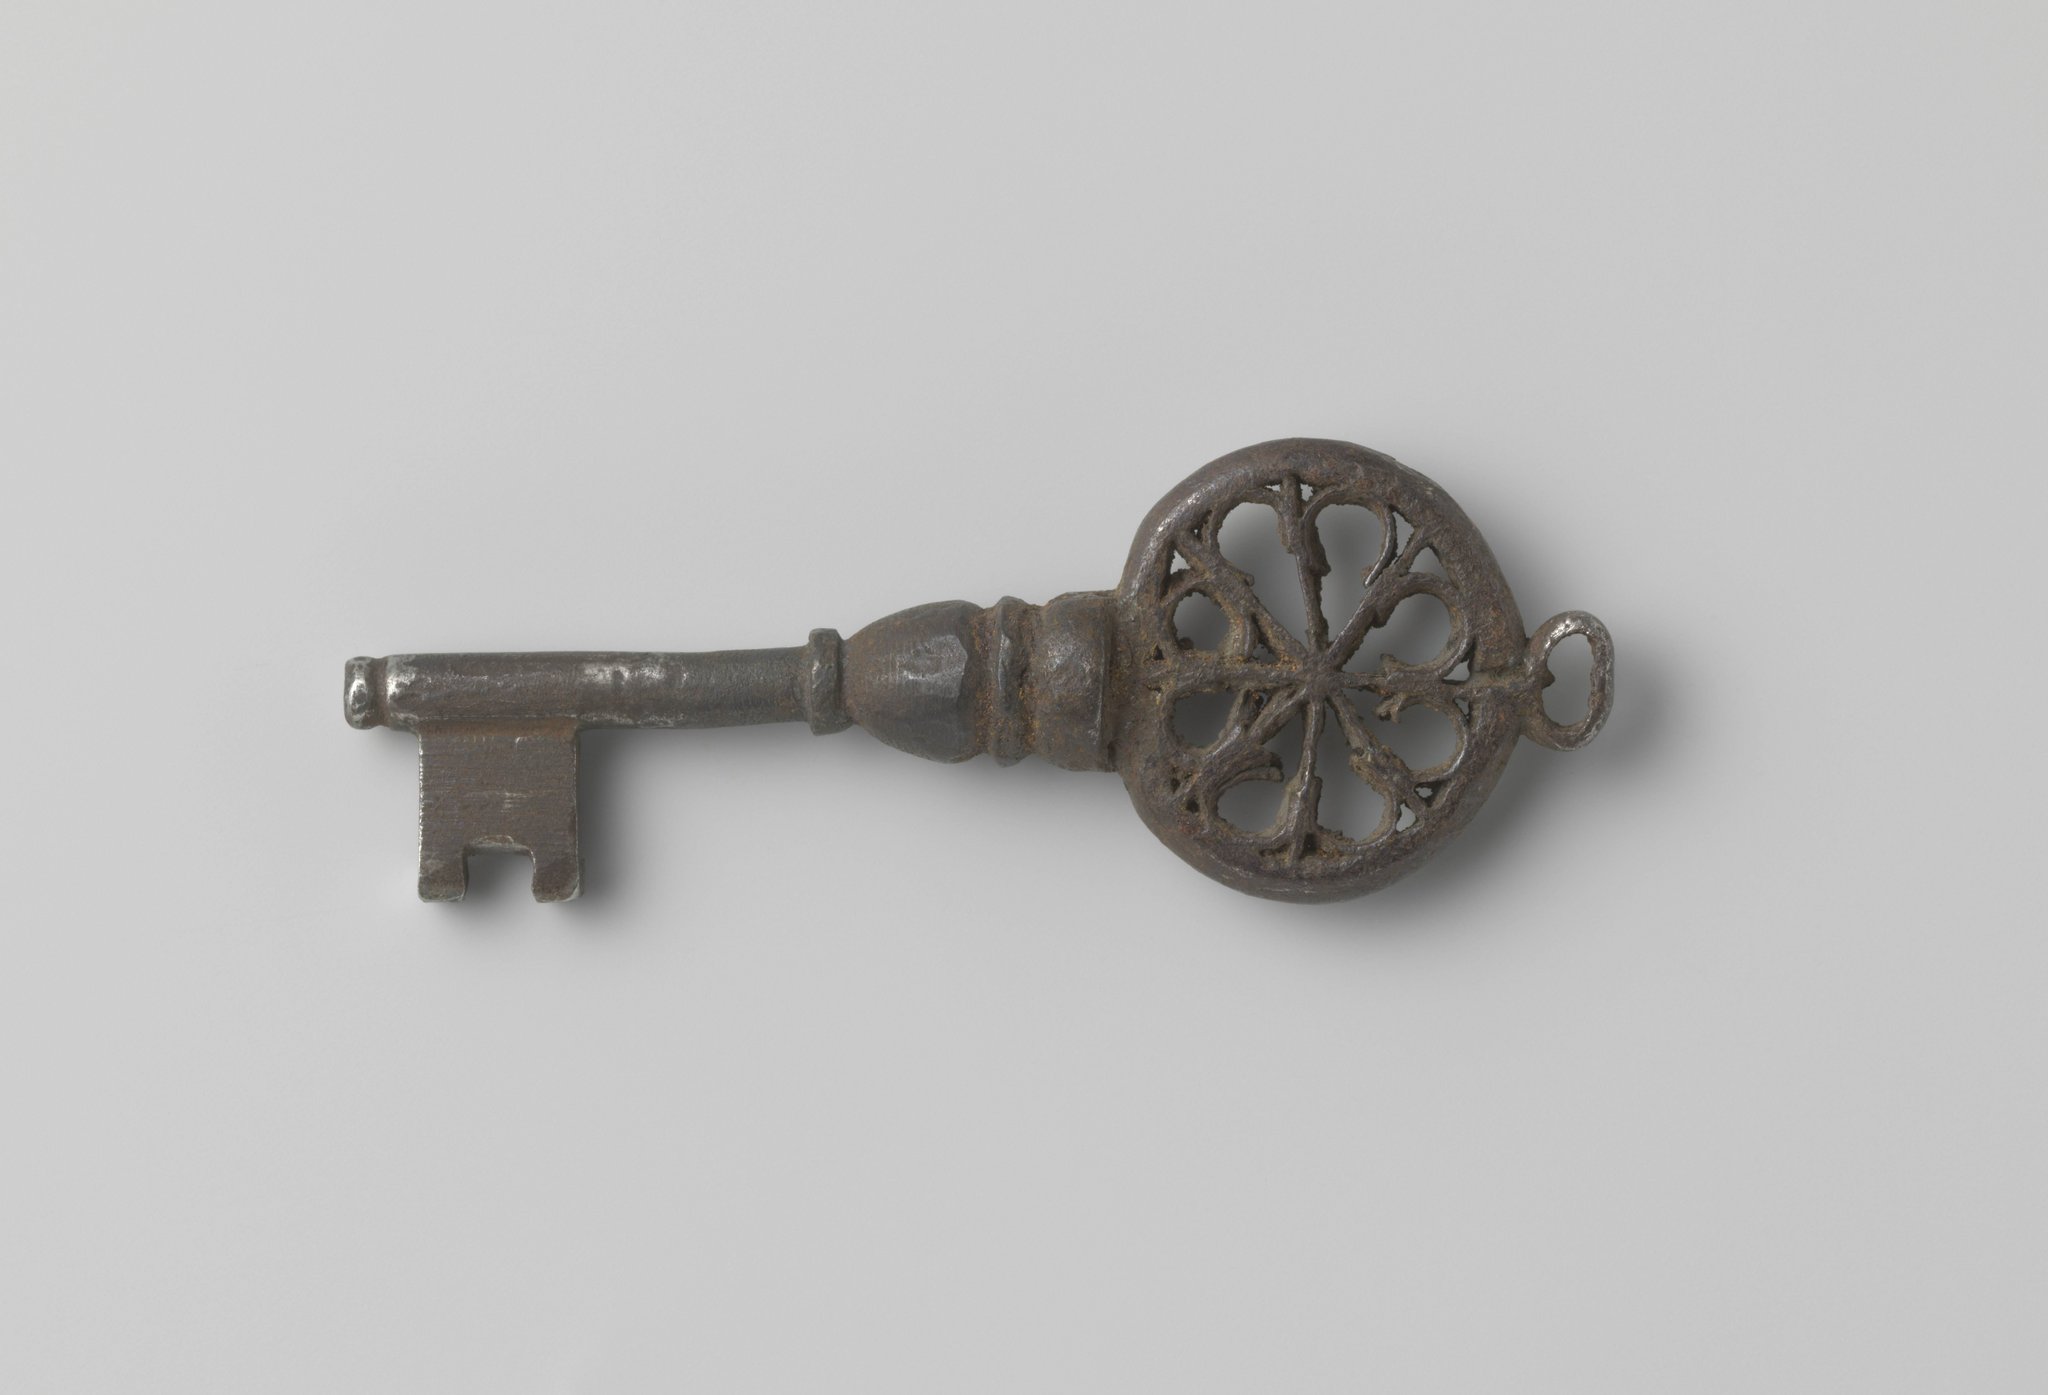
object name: key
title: Sleutel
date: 1700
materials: iron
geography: italy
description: Sleutel behorend bij twee hekdeuren BK-16959-A-TM-B. In de ring een stervormig ornament opgevuld met driekwart cirkels.